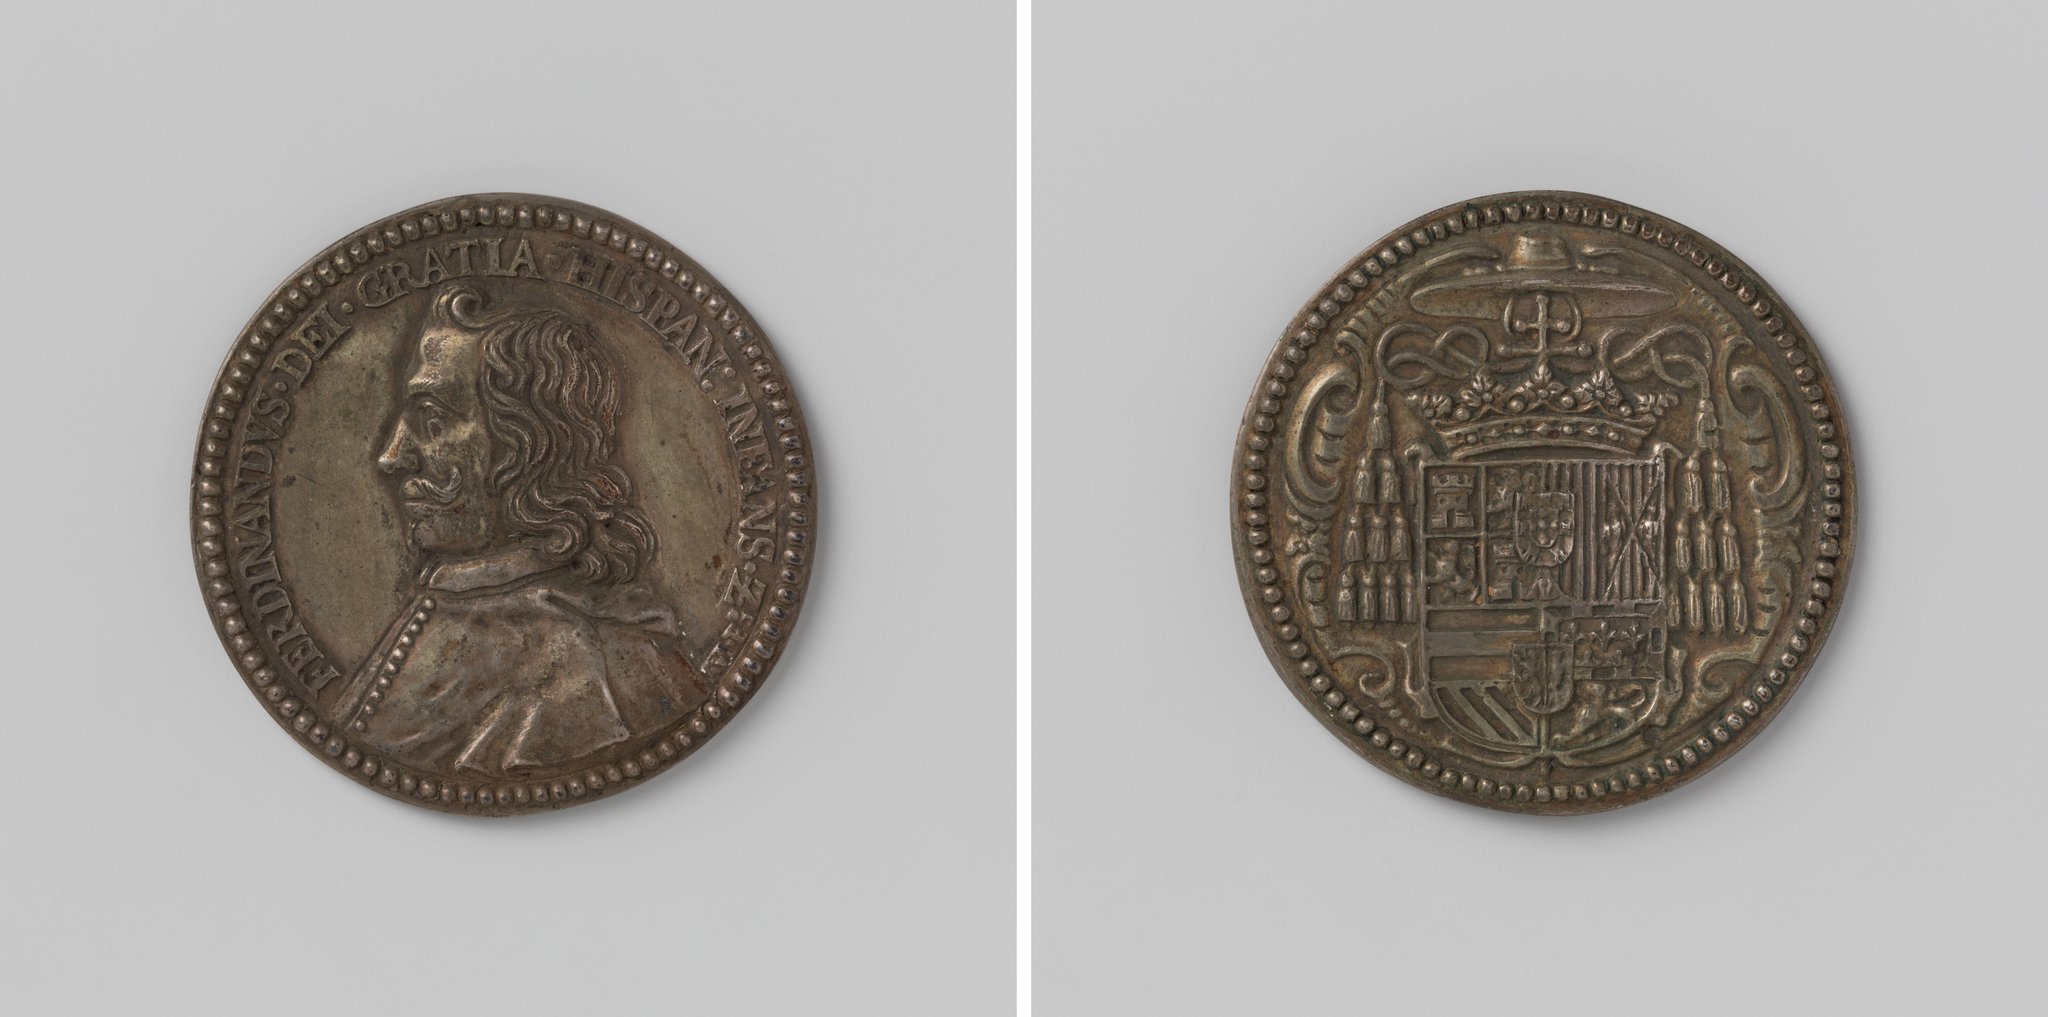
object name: history medal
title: Intrede van kardinaal-infant Ferdinand, als landvoogd der zuidelijke Nederlanden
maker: adriaan waterloos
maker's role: medailleur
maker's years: 1600-1684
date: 1634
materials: silver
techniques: gilding, striking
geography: brussels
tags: brussels, landvoogd der zuidelijke nederlanden ferdinand van oostenrijk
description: Zilveren penning. Voorzijde: borststuk man binnen omschrift. Keerzijde: zijn gekroond wapenschild bedekt met kardinaalshoed.